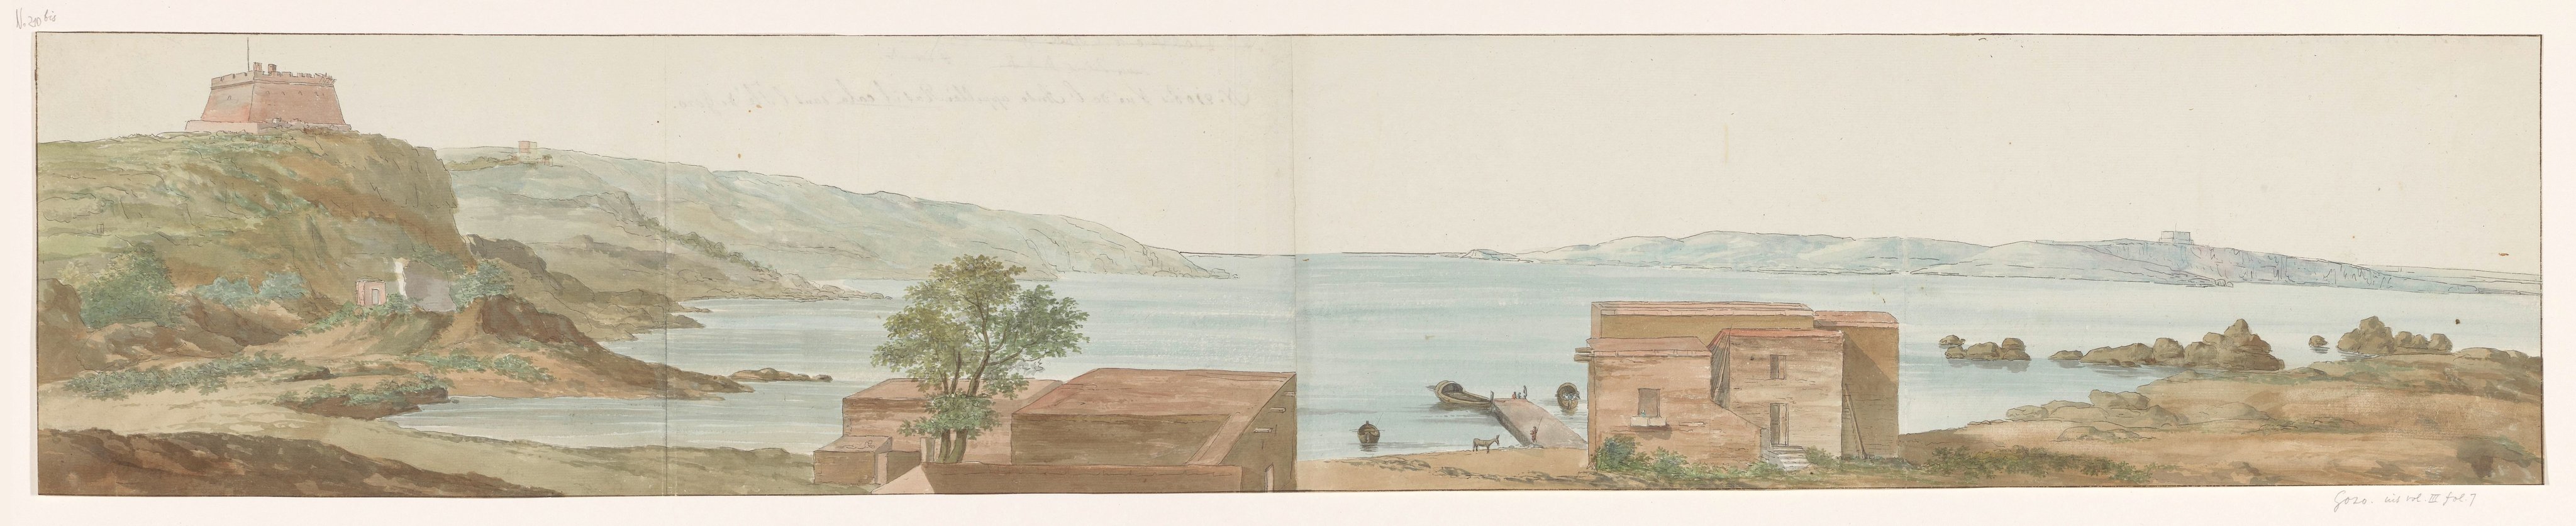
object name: drawing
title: Gezicht op baai Ras il cala op eiland Gozo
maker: louis ducros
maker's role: draughtsman, print maker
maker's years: 1748-1810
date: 1778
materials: chalk, paper, watercolor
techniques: brush, pen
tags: gulf, bay, city-view, and landscape with man-made constructions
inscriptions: inscription: ‘No 201 Vue de l'Anse appelée Ras il cala dans l'île de Ghozo’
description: Tekening uit het album 'Voyage en Italie, en Sicile et à Malte', 1778.